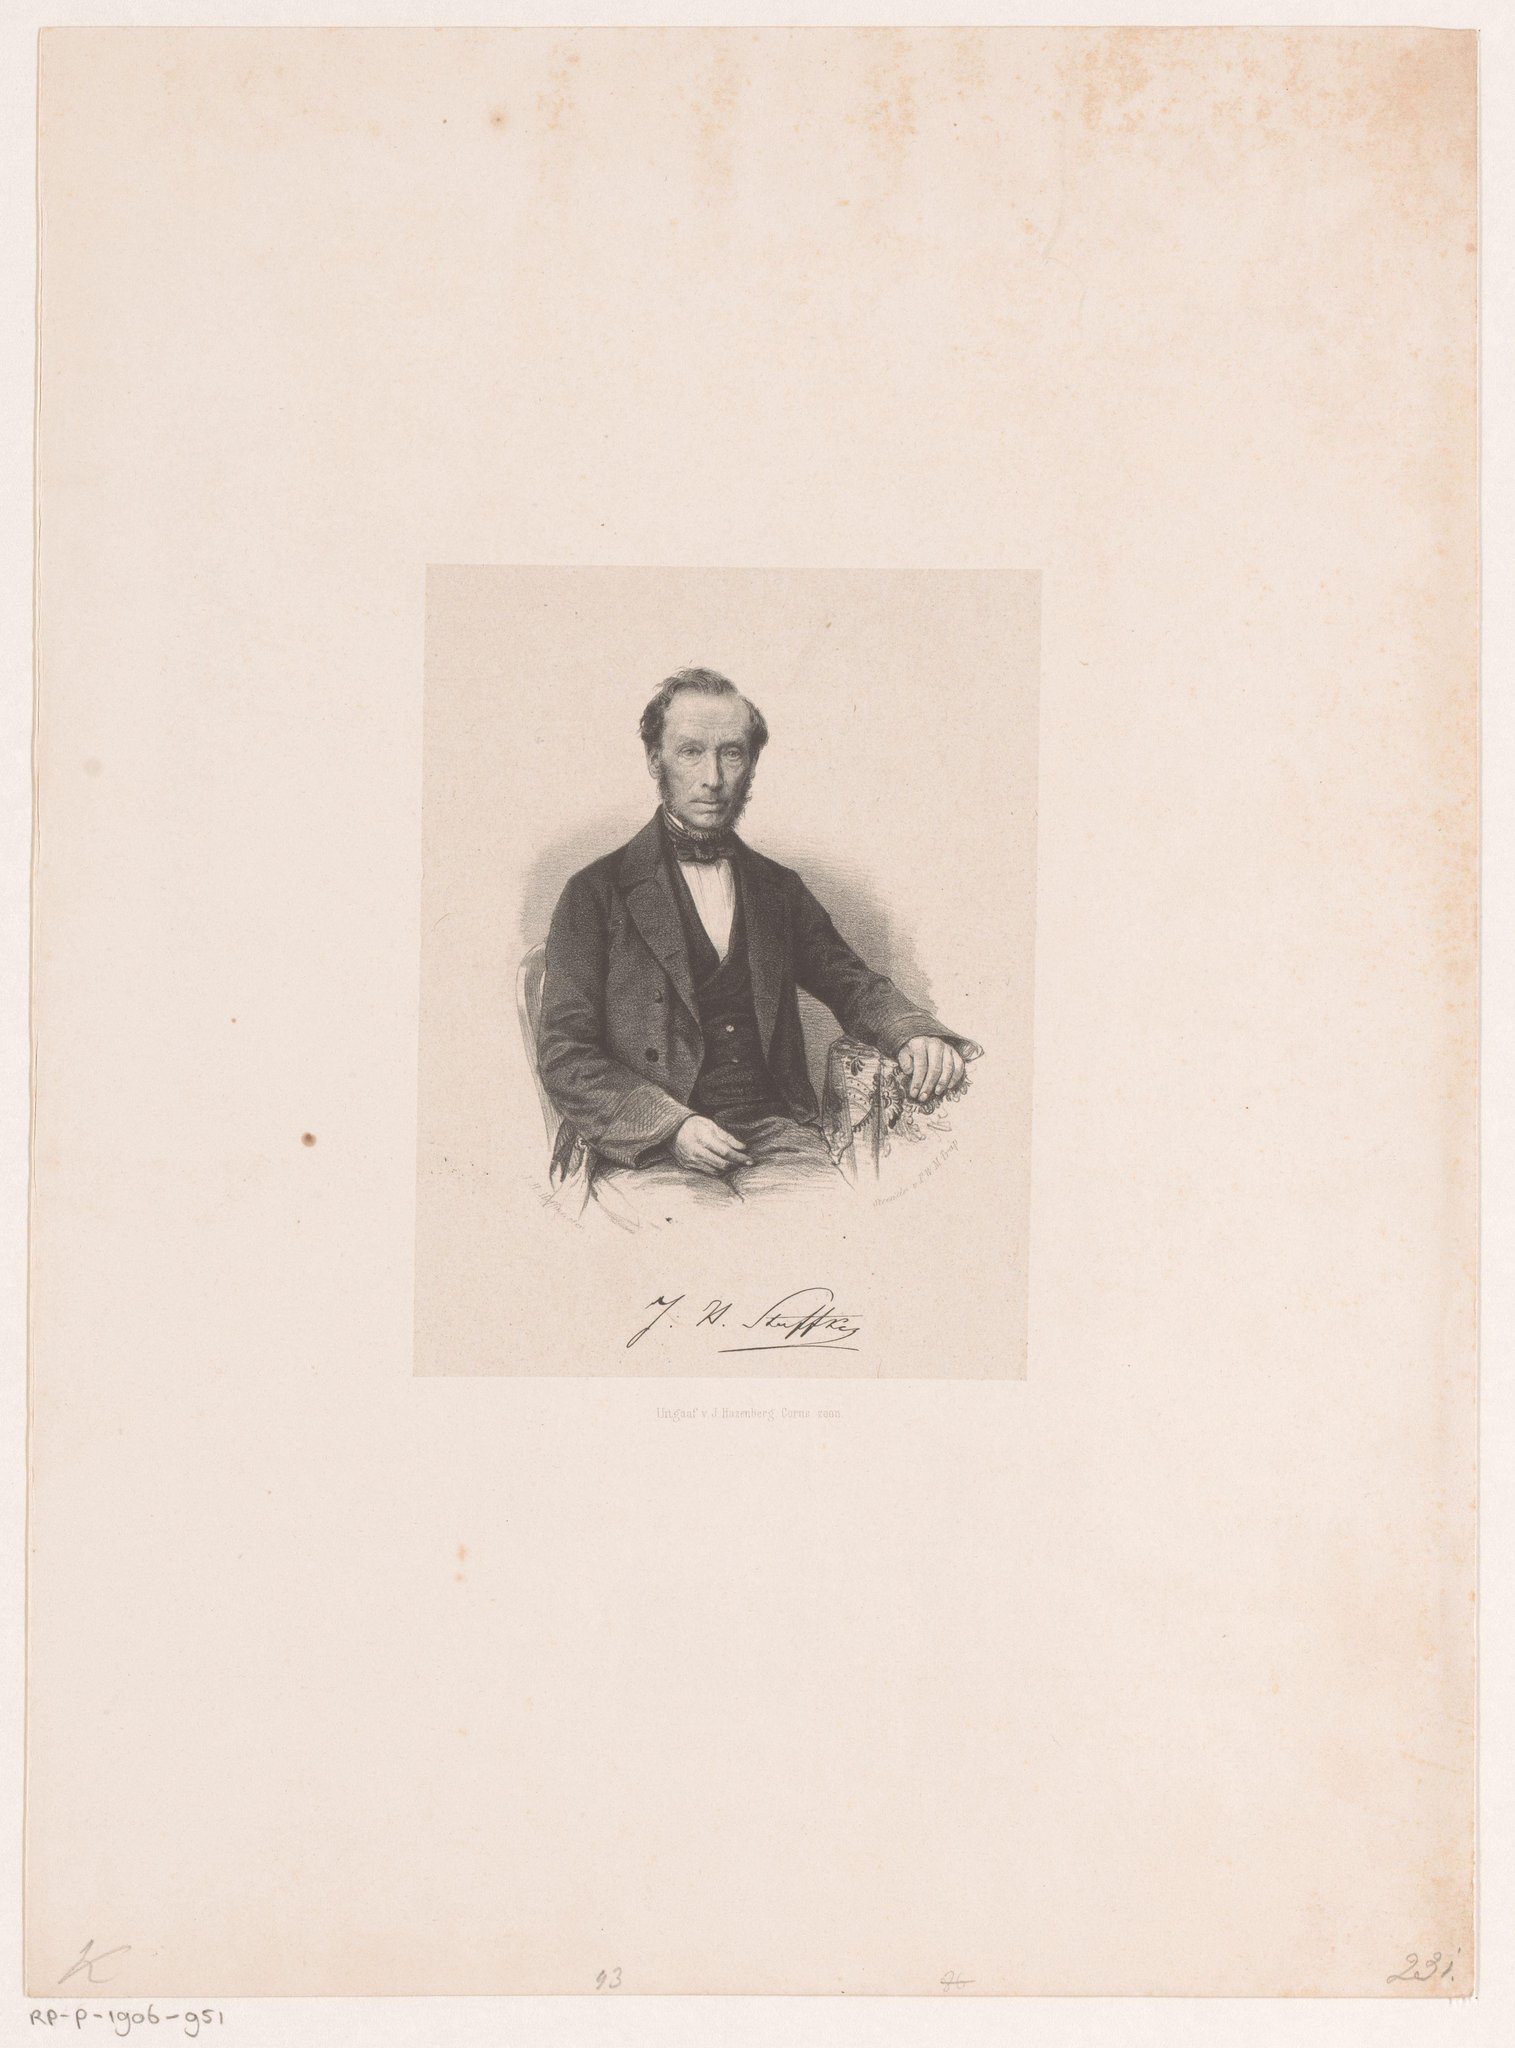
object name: print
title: Portret van Jan Hendrik Stuffken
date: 1843-1891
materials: paper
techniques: lithograph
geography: netherlands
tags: amsterdam, arnhem, historical persons (+ (full) bust portrait)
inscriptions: collector's mark: Lugt 2228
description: Onder het portret de signatuur van de geportretteerde.